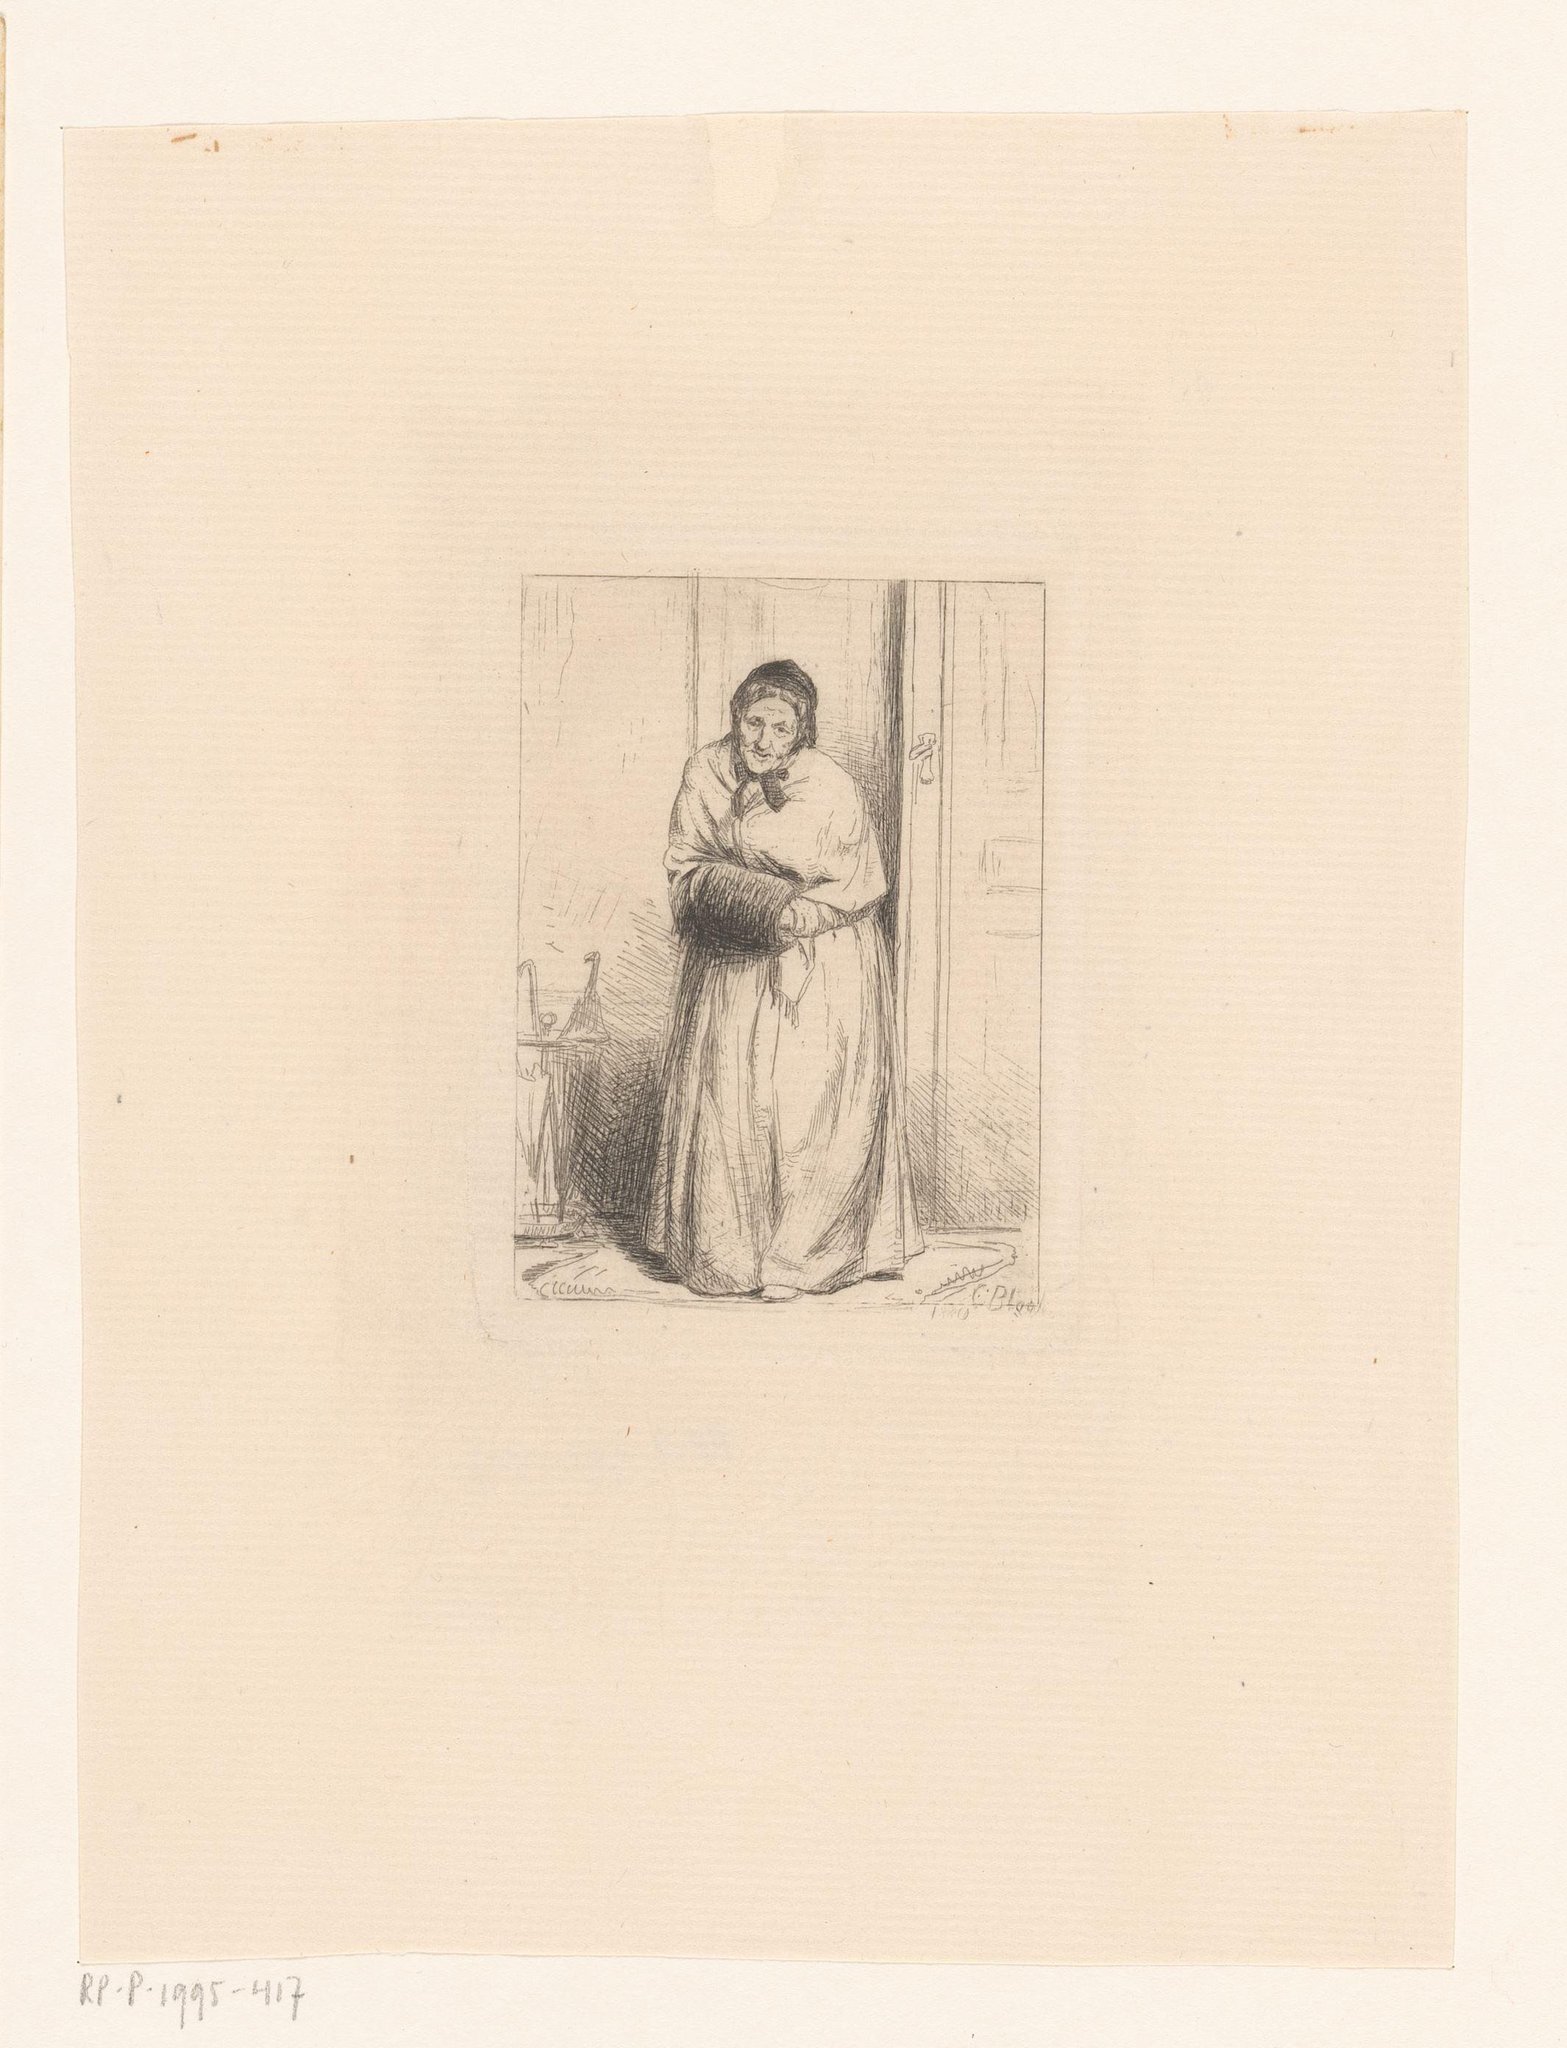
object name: print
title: Vrouw met mof, bij een huisdeur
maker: carl bloch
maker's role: print maker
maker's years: 1834-1890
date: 1880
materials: paper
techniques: drypoint, etching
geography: scandinavia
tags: muff, old woman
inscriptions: signature and date: ‘r.o. 1880 C Bloch’, collector's mark: Lugt 2228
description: Vrouw, de handen in een mof, hoofddoek, staat bij een huisdeur. Links een paraplubak.